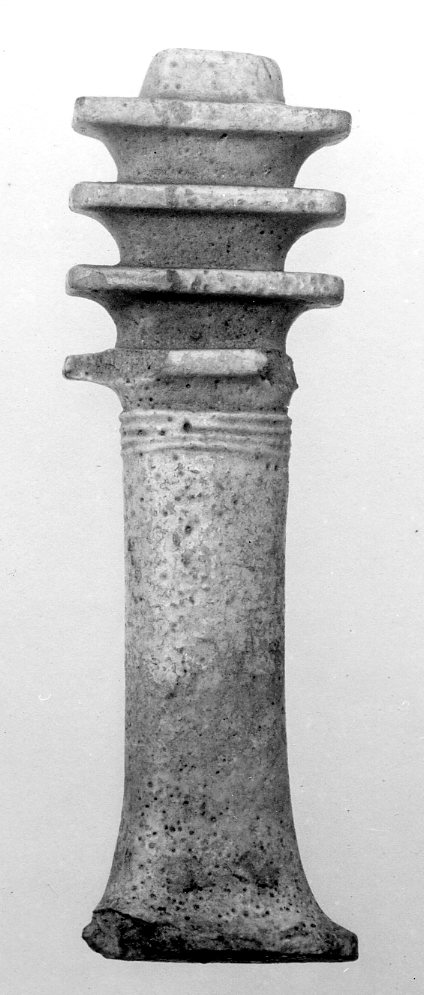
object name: amulet, djed pillar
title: Djed pillar Amulet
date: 664-332 BCE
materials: faience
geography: egypt